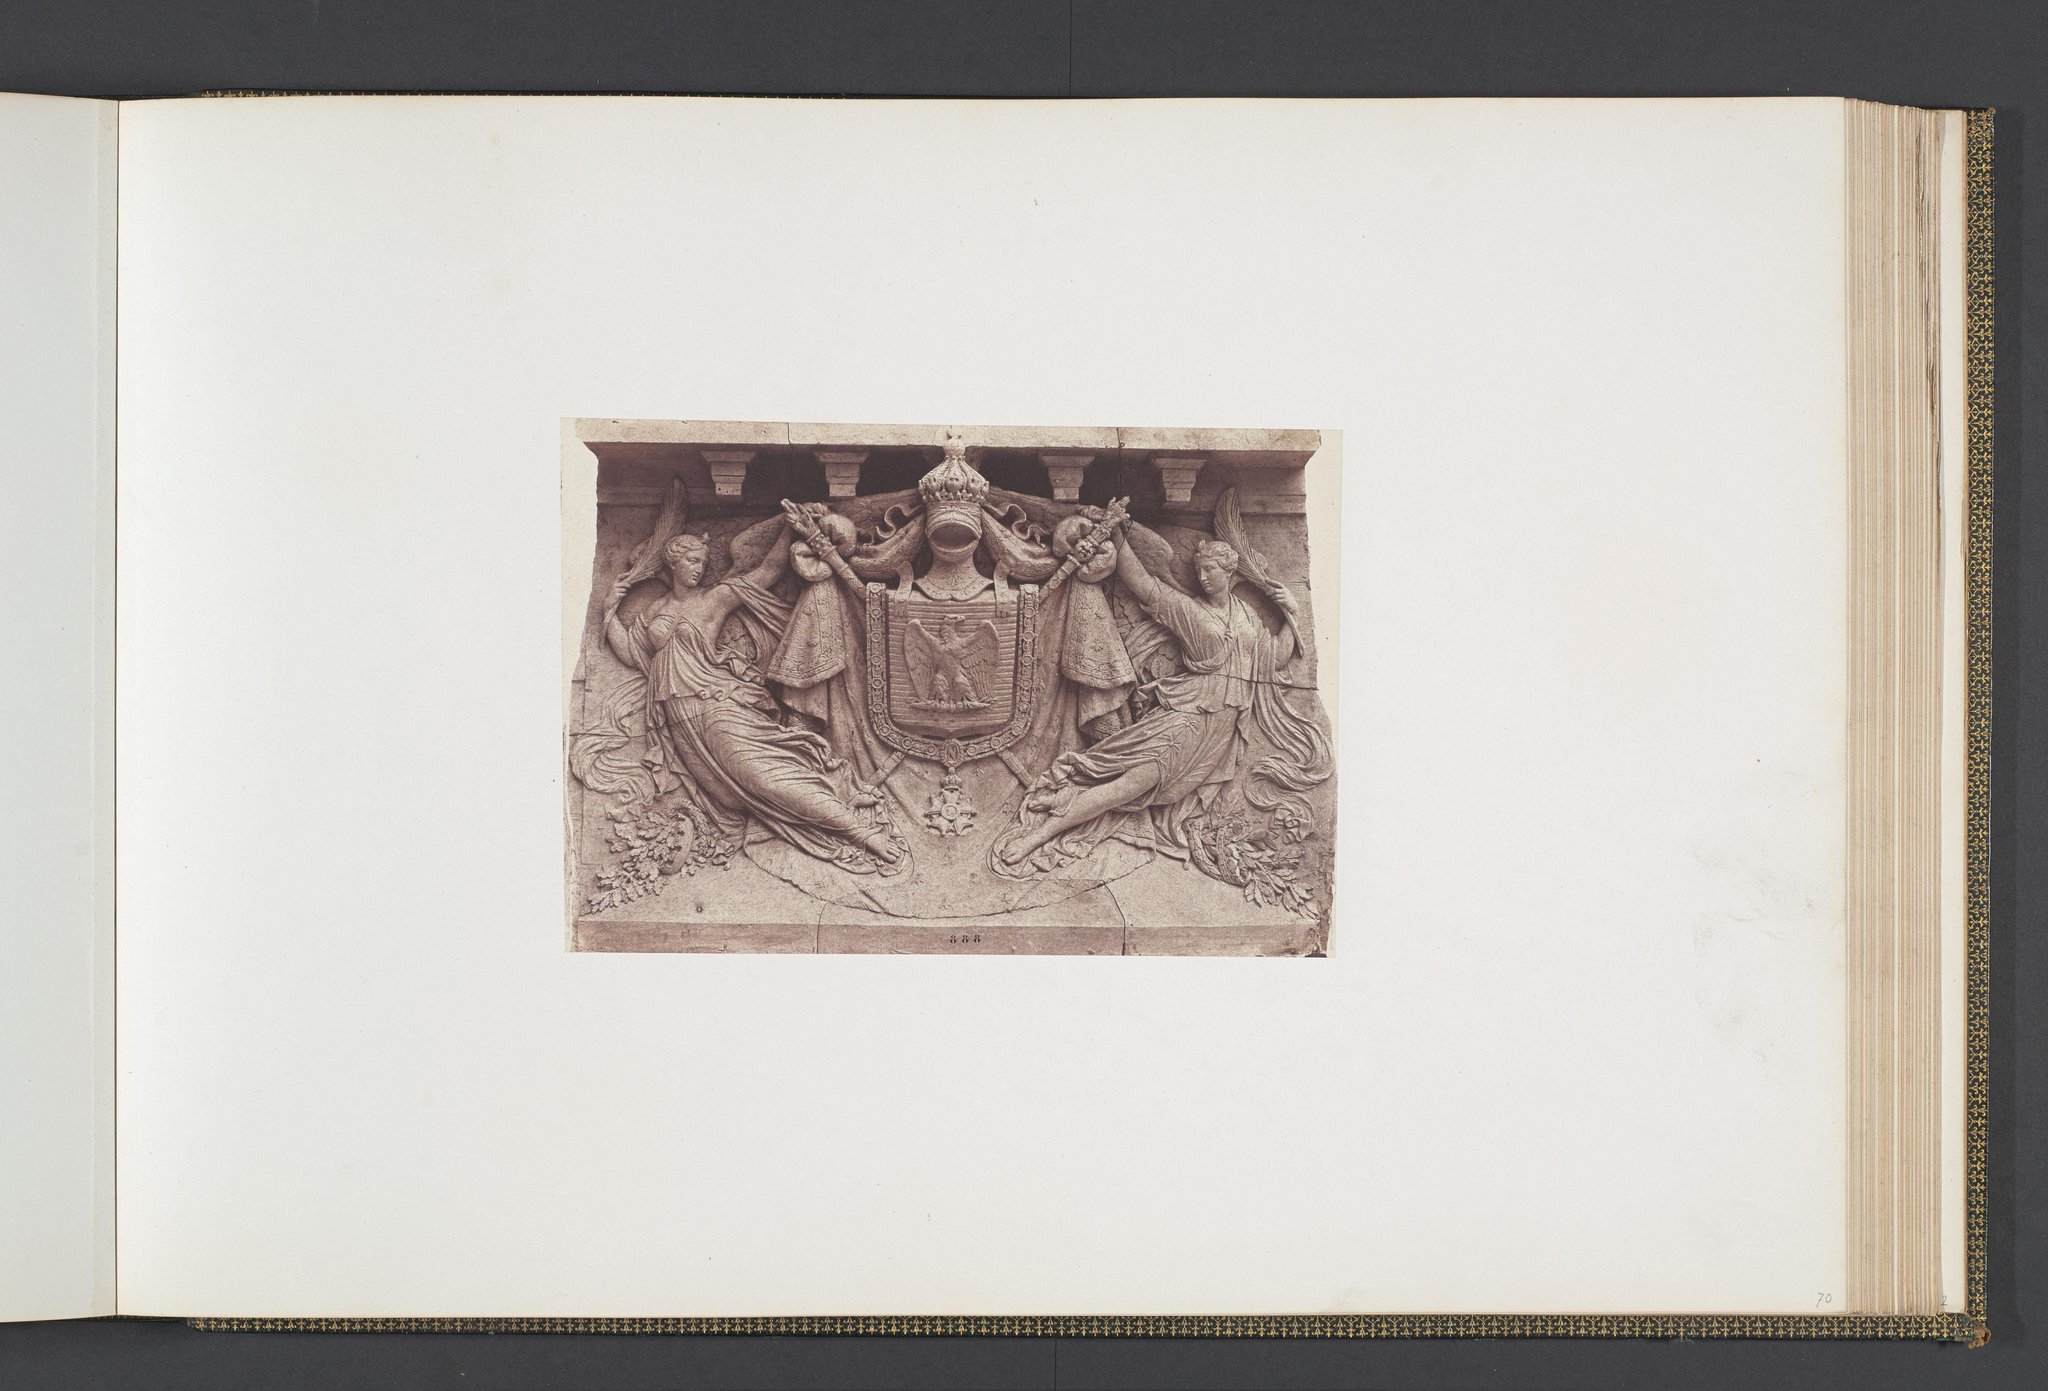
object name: album leaf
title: Gipsmodel voor beeldhouwwerk op het Palais du Louvre: "Le Courage civique et la Gloire" door Théodore Gruyère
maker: édouard denis baldus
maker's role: fotograaf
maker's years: 1813-1889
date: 1855-1857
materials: paper, photographic support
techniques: salted paper print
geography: paris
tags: piece of sculpture, reproduction of a piece of sculpture, permanent exhibition, museum, paris, tuileries palace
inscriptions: number: ‘888’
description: Onderdeel van Réunion des Tuileries au Louvre 1852-1857, album 2.